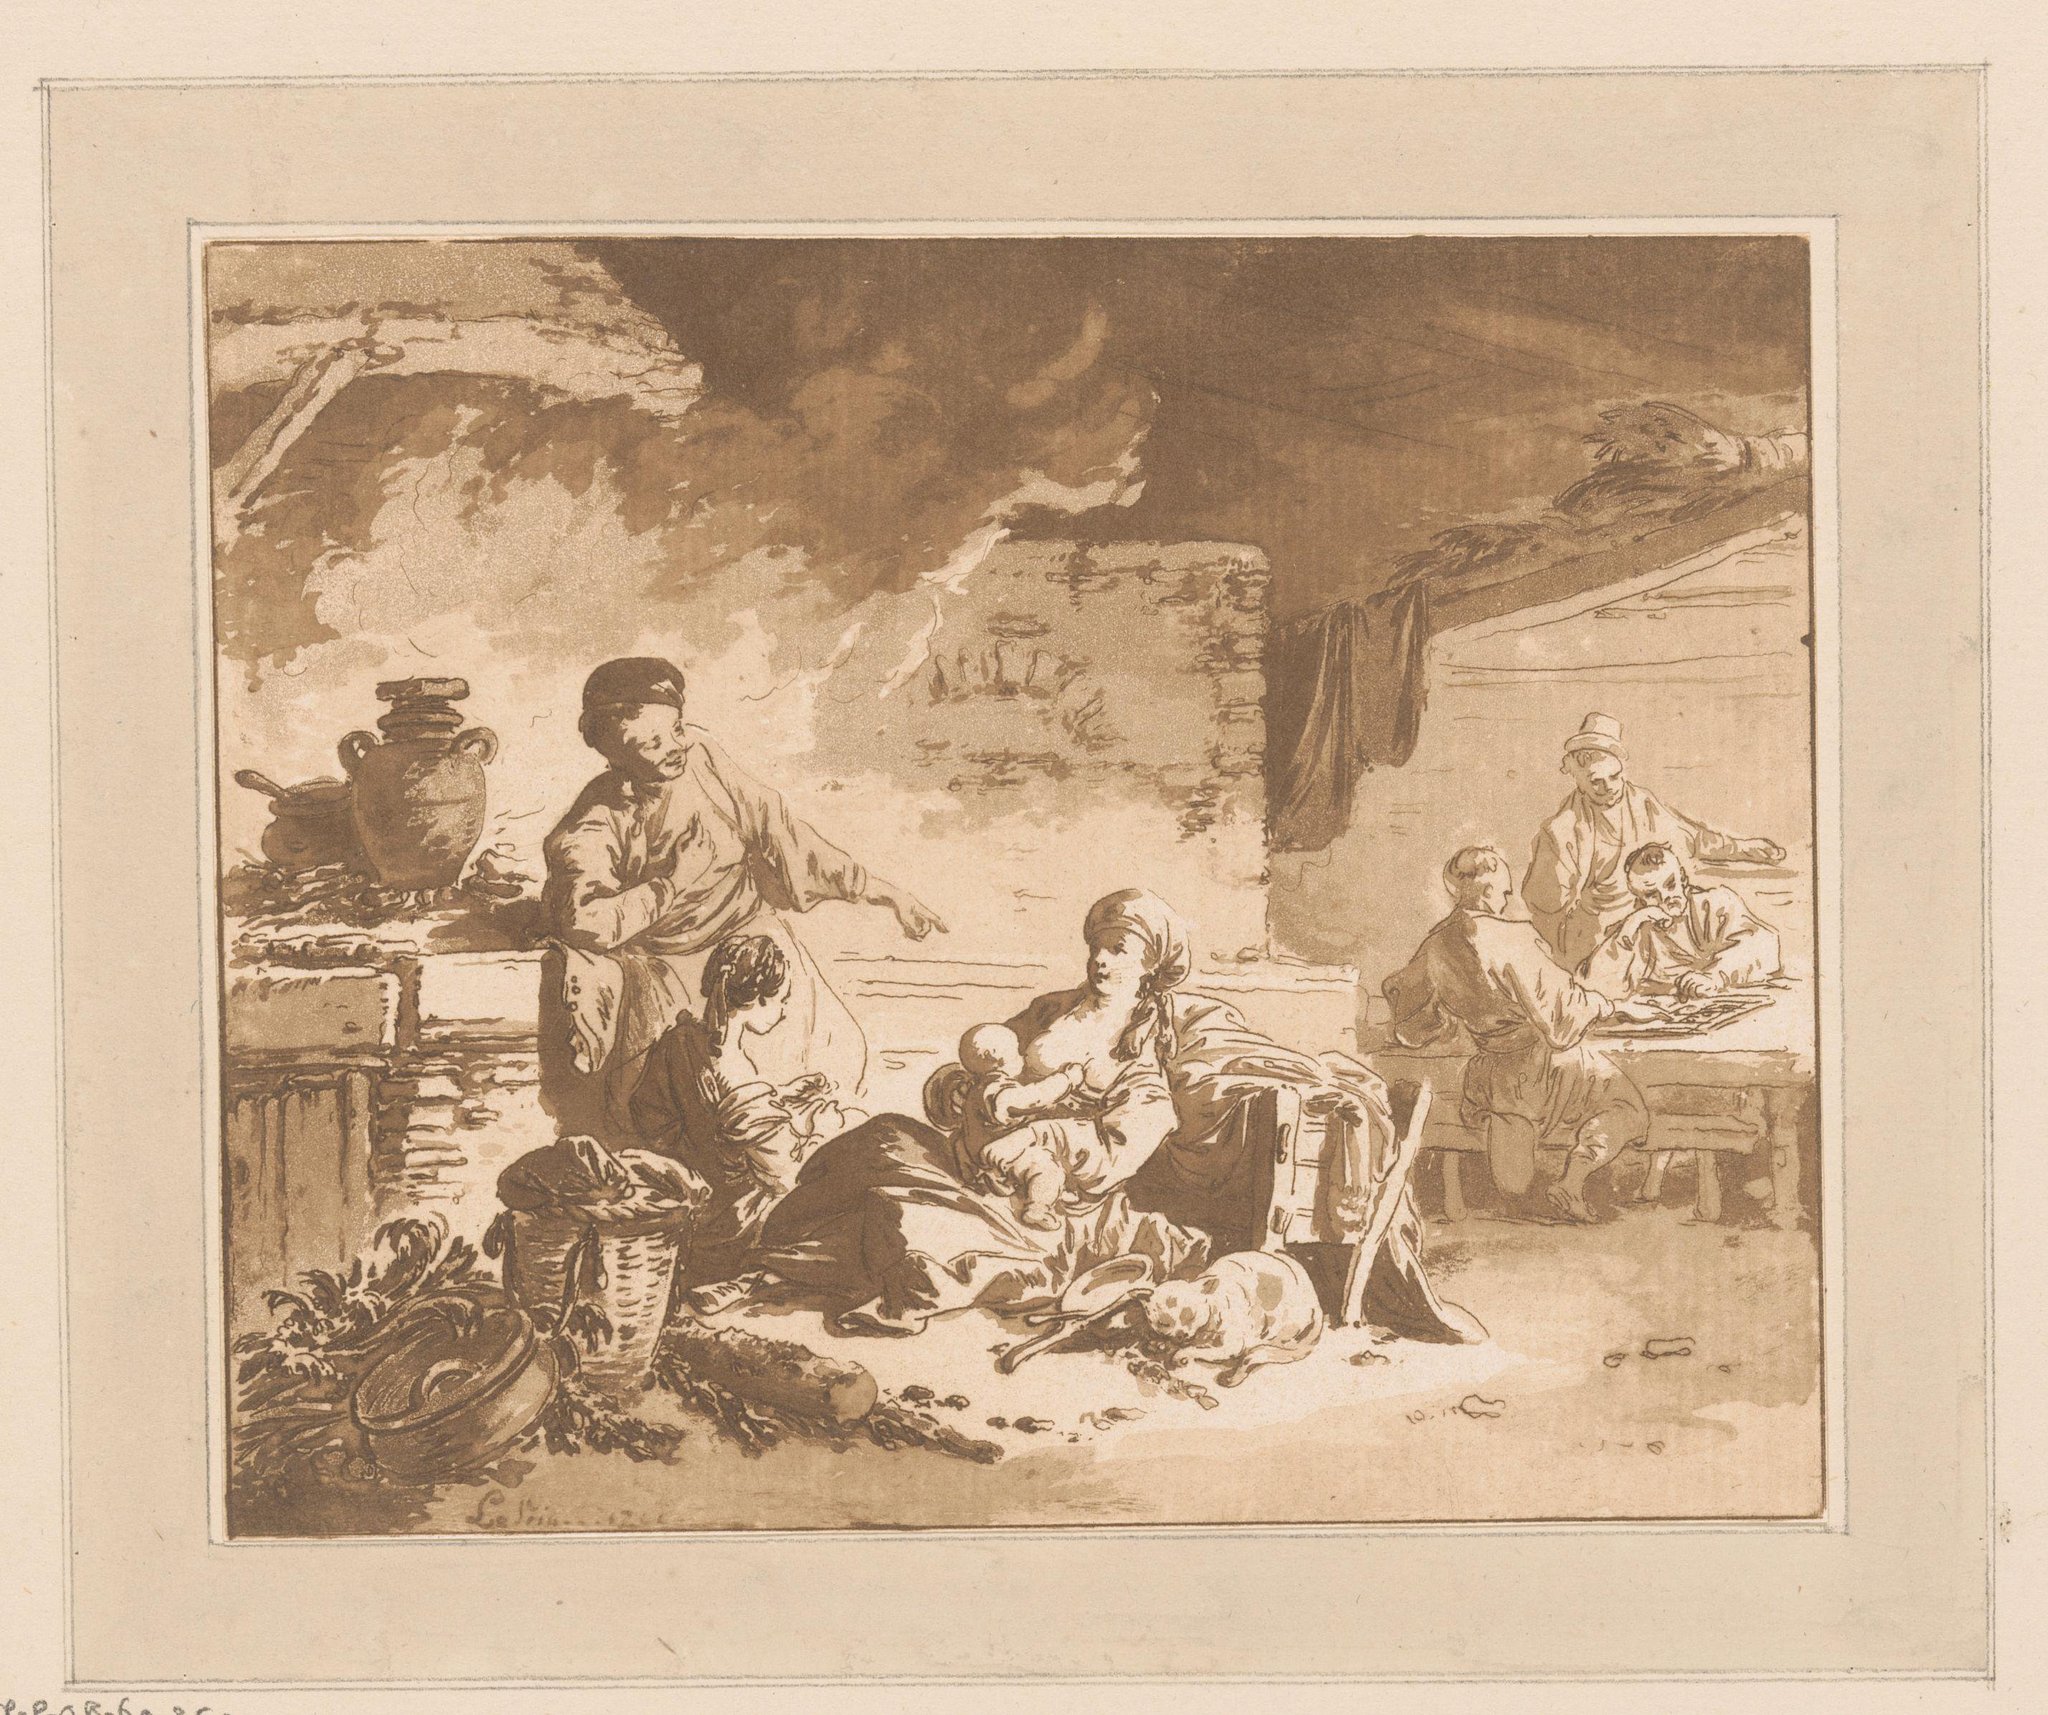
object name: print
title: Herberginterieur met figuren en in het midden een vrouw die een kind voedt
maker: jean baptist leprince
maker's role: draughtsman, print maker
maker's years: 1734-1781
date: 1768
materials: paper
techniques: aquatint, etching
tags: cat, feeding a baby, hotel, hostelry, inn